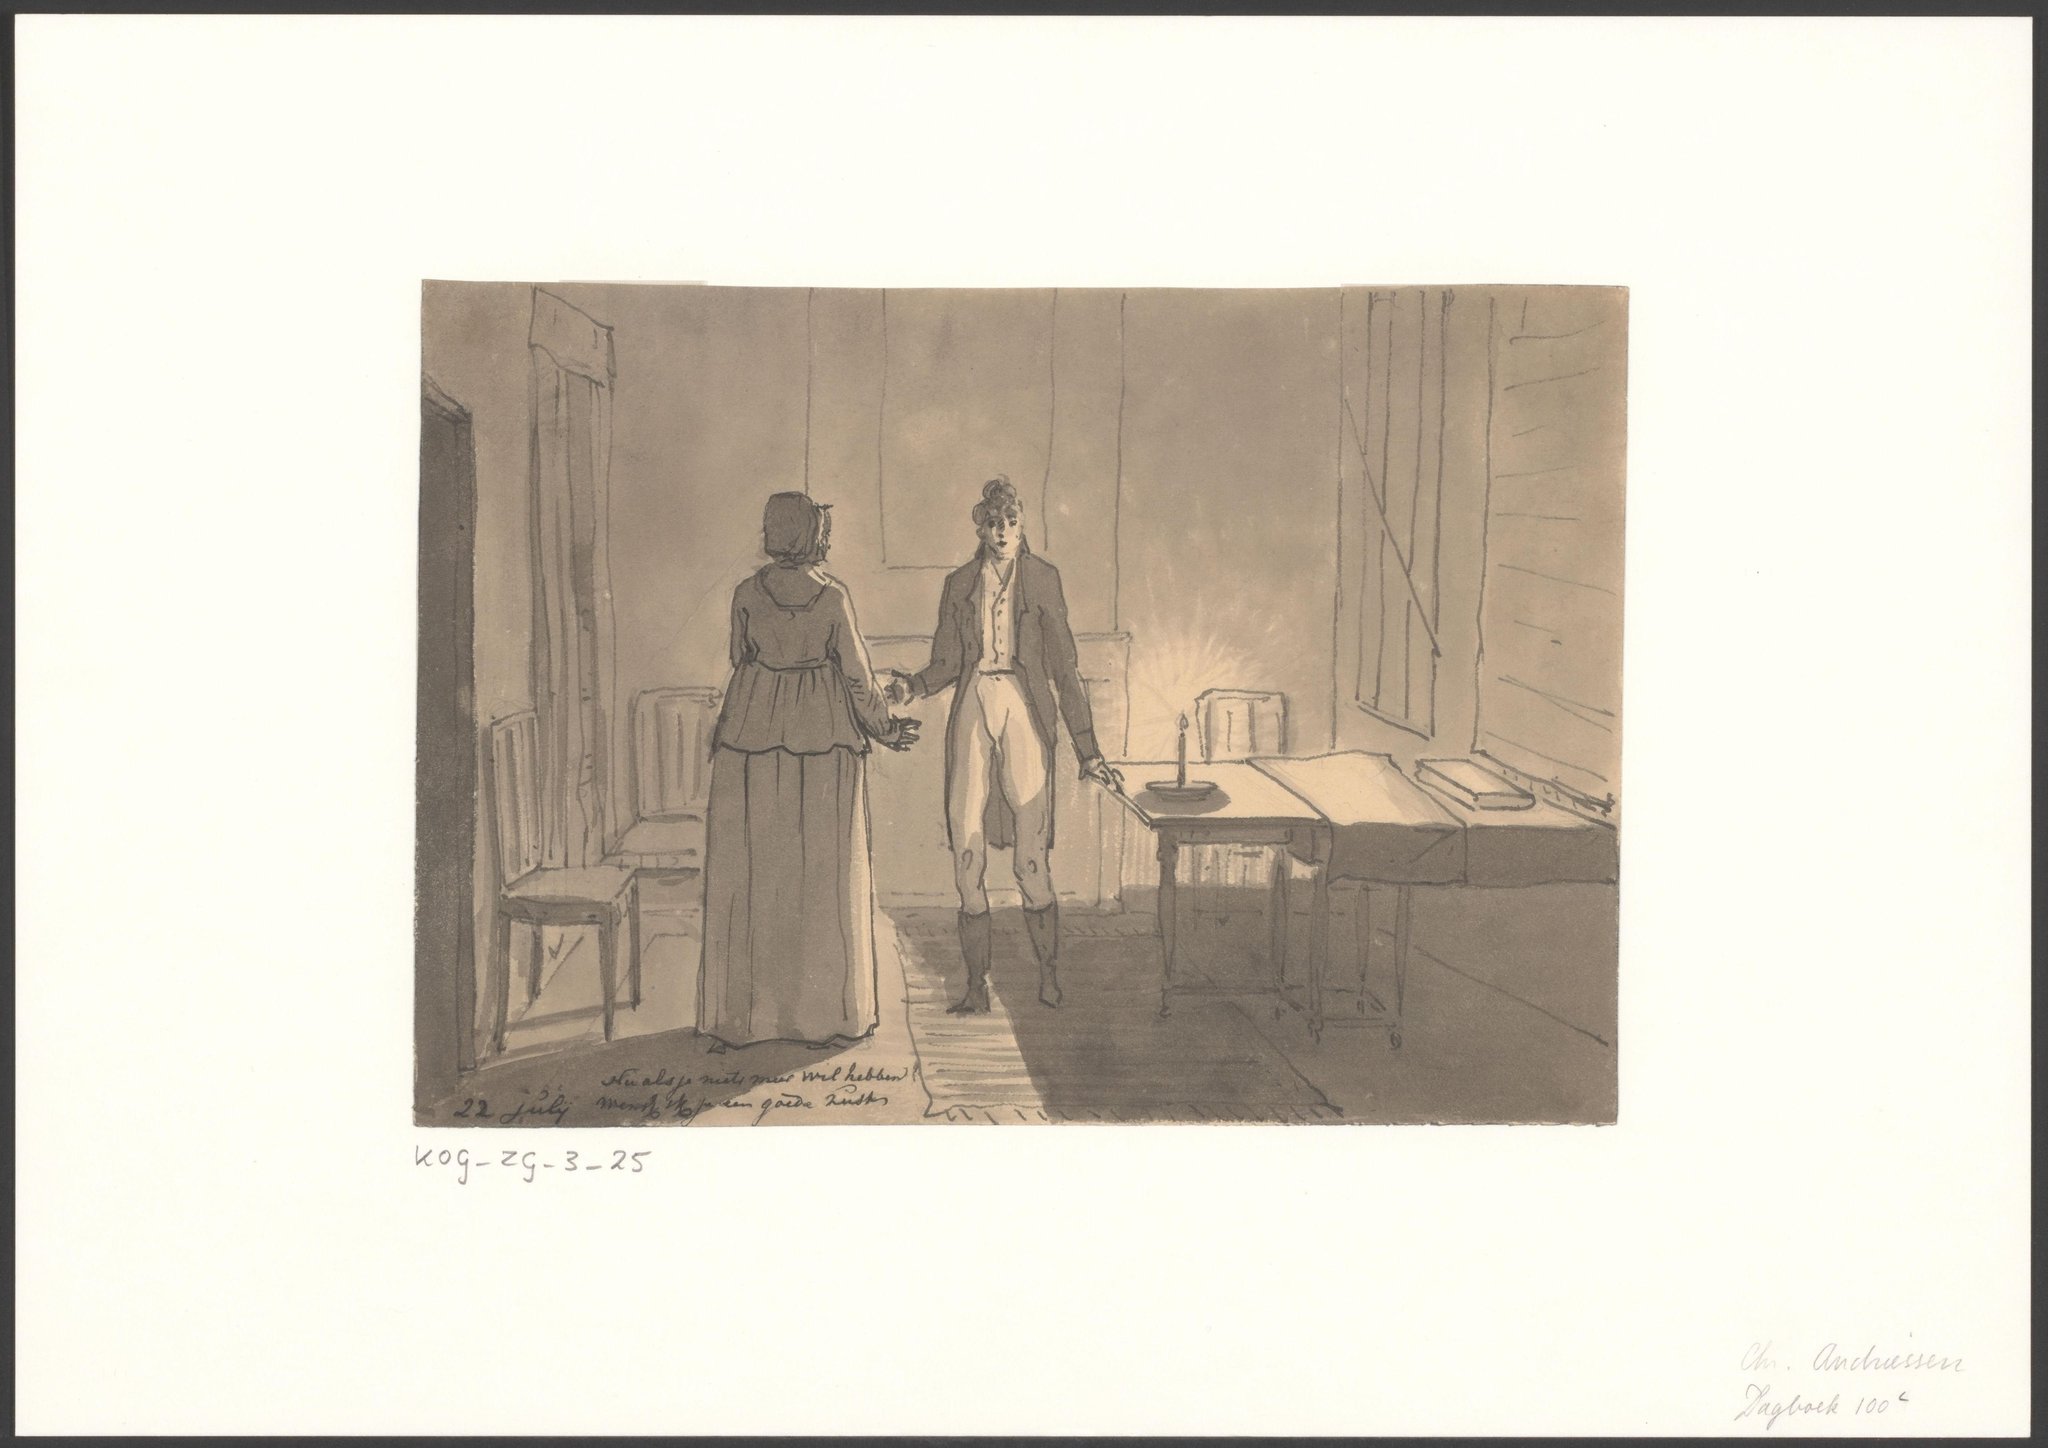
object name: drawing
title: Christiaan Andriessen komt laat thuis en een vrouw wenst hem een goede nacht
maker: christiaan andriessen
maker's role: draughtsman, print maker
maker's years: 1775-1846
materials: ink, paper, pencil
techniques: brush, pen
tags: coffee-pot, interior of the house, living-room, parlour, sitting-room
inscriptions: inscription: ‘J Andriessen’, inscription: ‘Nu als je niets meer wil hebben wensch ik je goede nacht’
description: Dagboekblad uit het getekende dagboek dat Christiaan Andriessen bijhield van 1805 tot en met 1808.